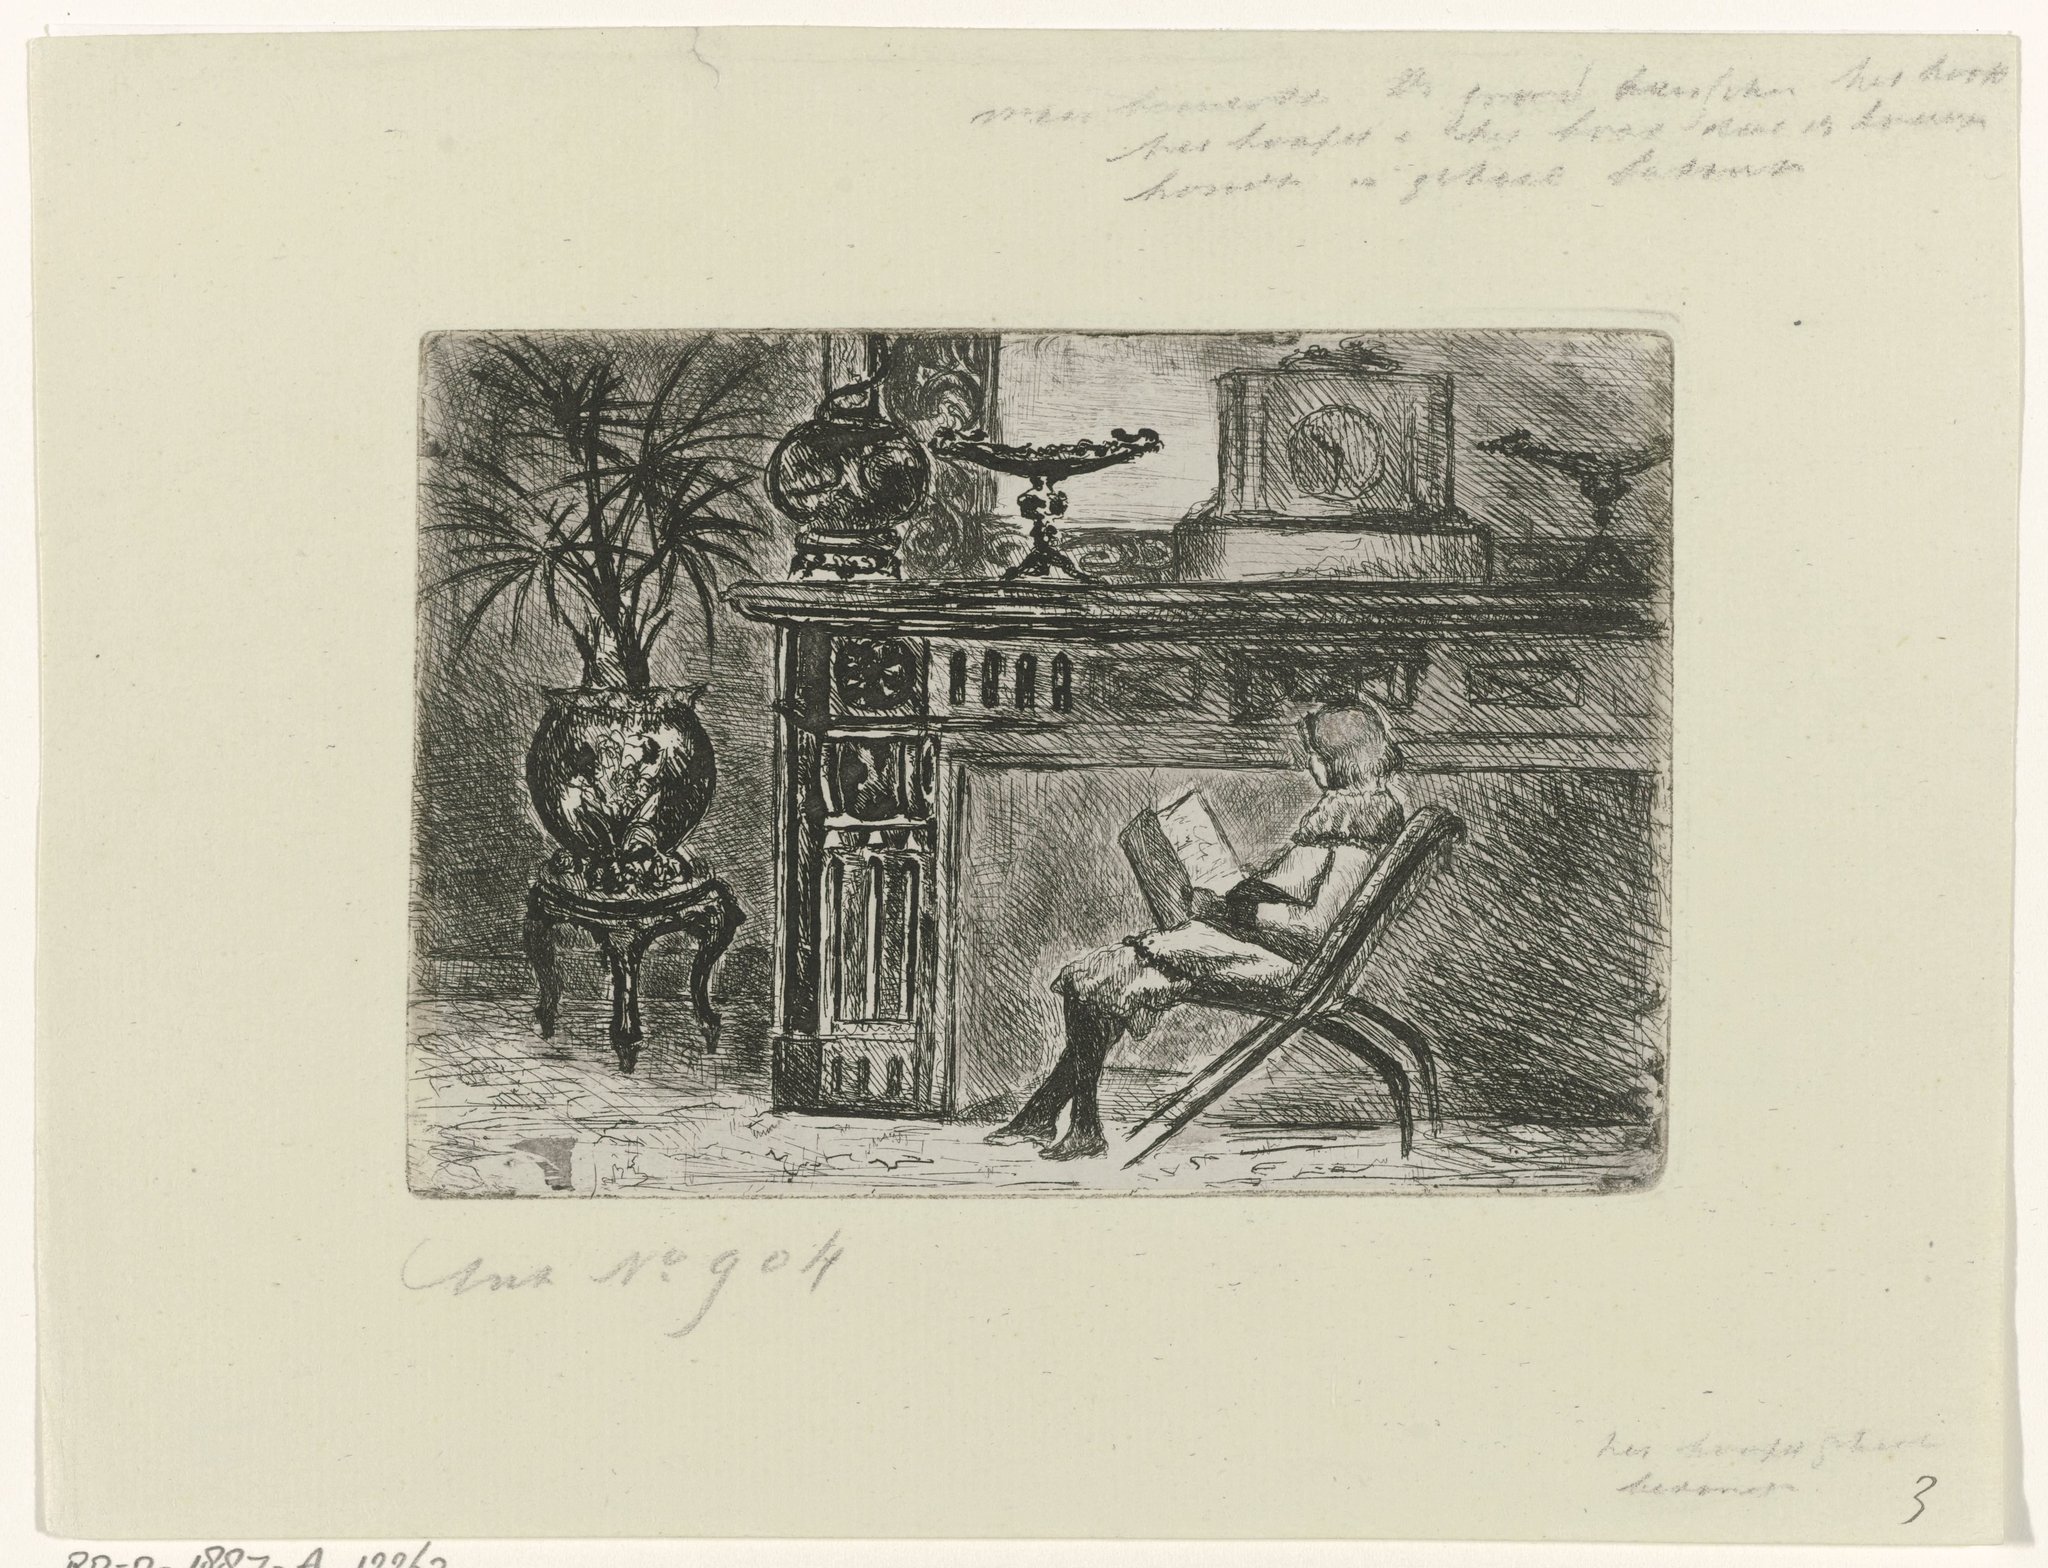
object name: print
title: Lezende man voor schoorsteen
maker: Anonymous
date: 1800-1887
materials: paper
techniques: etching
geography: netherlands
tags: chimney, reading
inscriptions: collector's mark: Lugt 2228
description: Een jongeman zit op een stoel voor een haard te lezen. Op de schoorsteenmantel een klok. Links in de kamer een plant in een pot op een tafeltje.